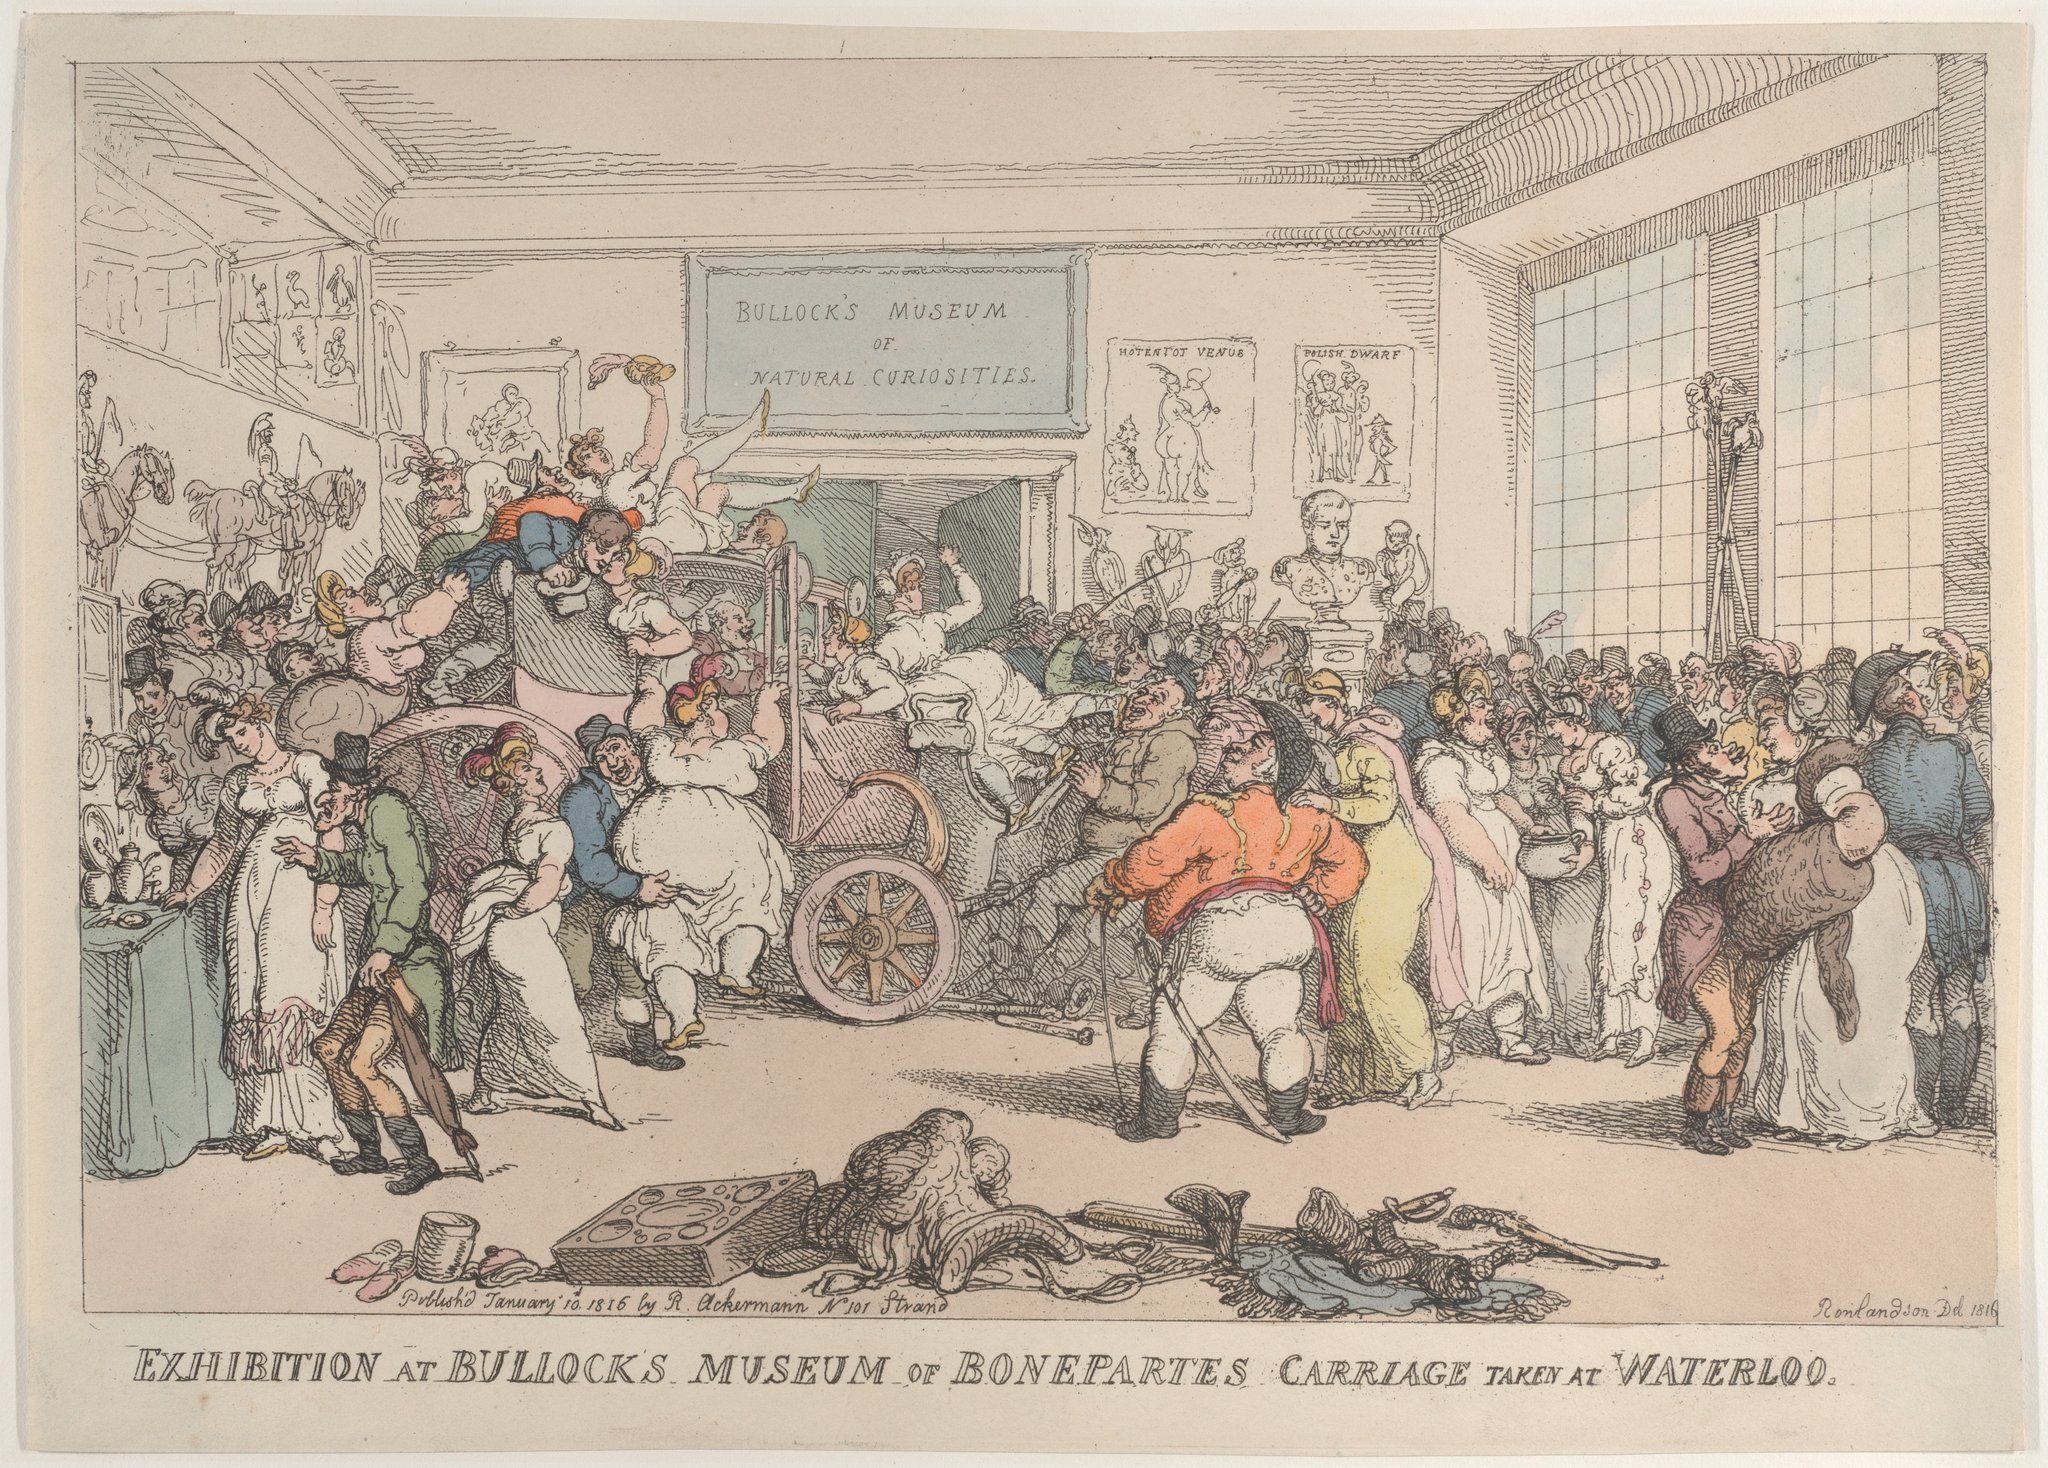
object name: print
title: Exhibition at Bullock's Museum of Bonaparte's Carriage Taken at Waterloo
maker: thomas rowlandson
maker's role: artist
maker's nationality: british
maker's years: 1757-1827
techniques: etching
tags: satire,napoleon i,men,women,carriages